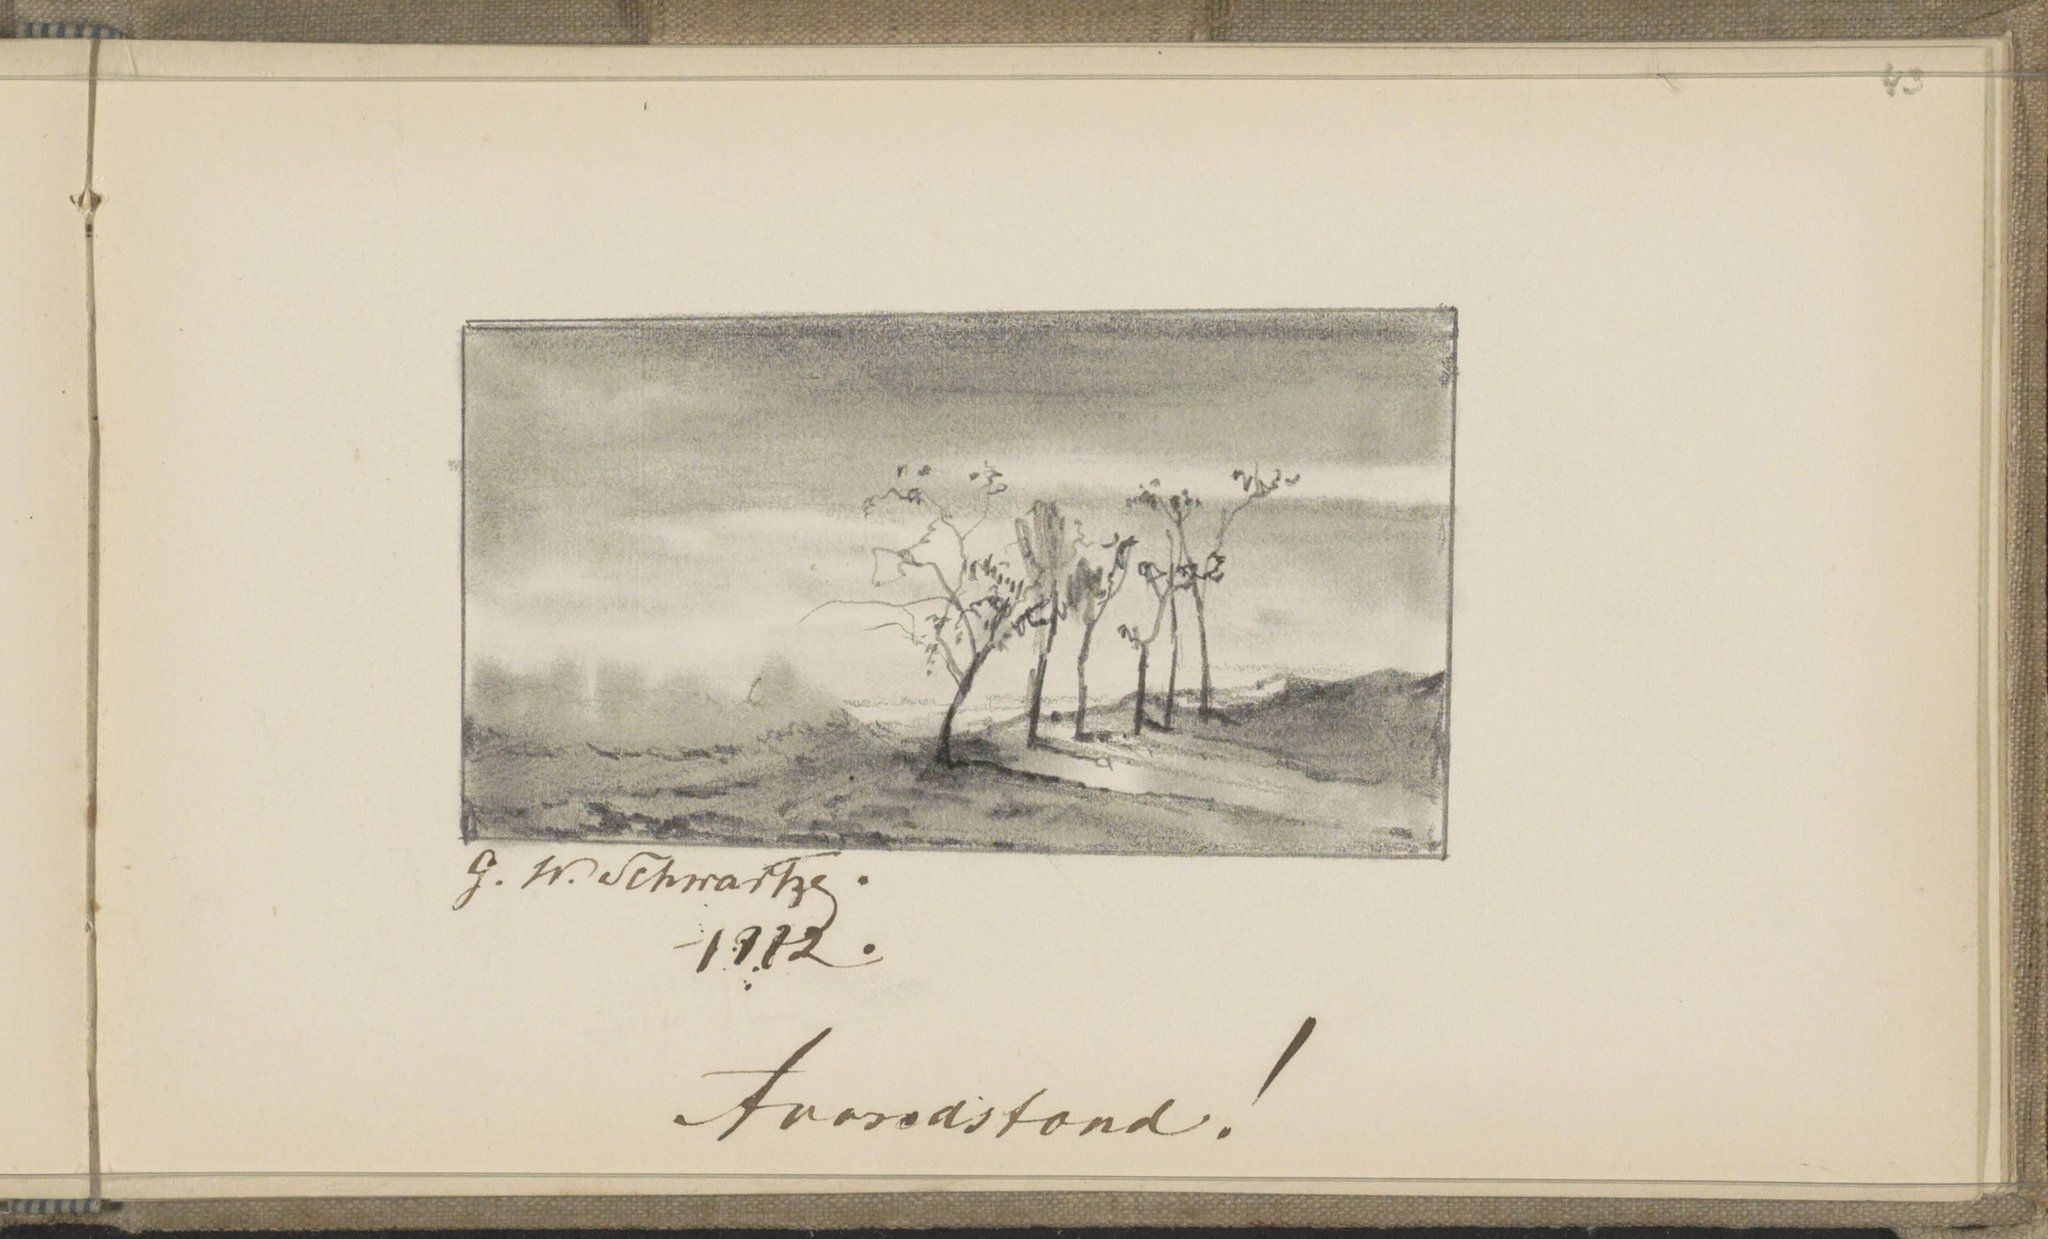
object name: sketchbook leaf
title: Landschap met bomen bij avond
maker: george washington schwartze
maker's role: draughtsman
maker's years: 1857-1909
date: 1882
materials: paper, pencil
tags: dusk, evening twilight, landscapes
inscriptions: title: ‘Avondstond!’, signature and date: ‘G.W. Schwartze./ 1882.’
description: Tekening in een kader. Blad 43 recto uit een schetsboek met 54 bladen.